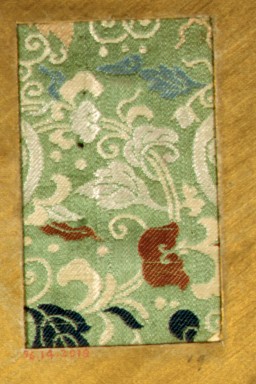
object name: piece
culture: japanese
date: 1701-1900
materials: silk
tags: flowers